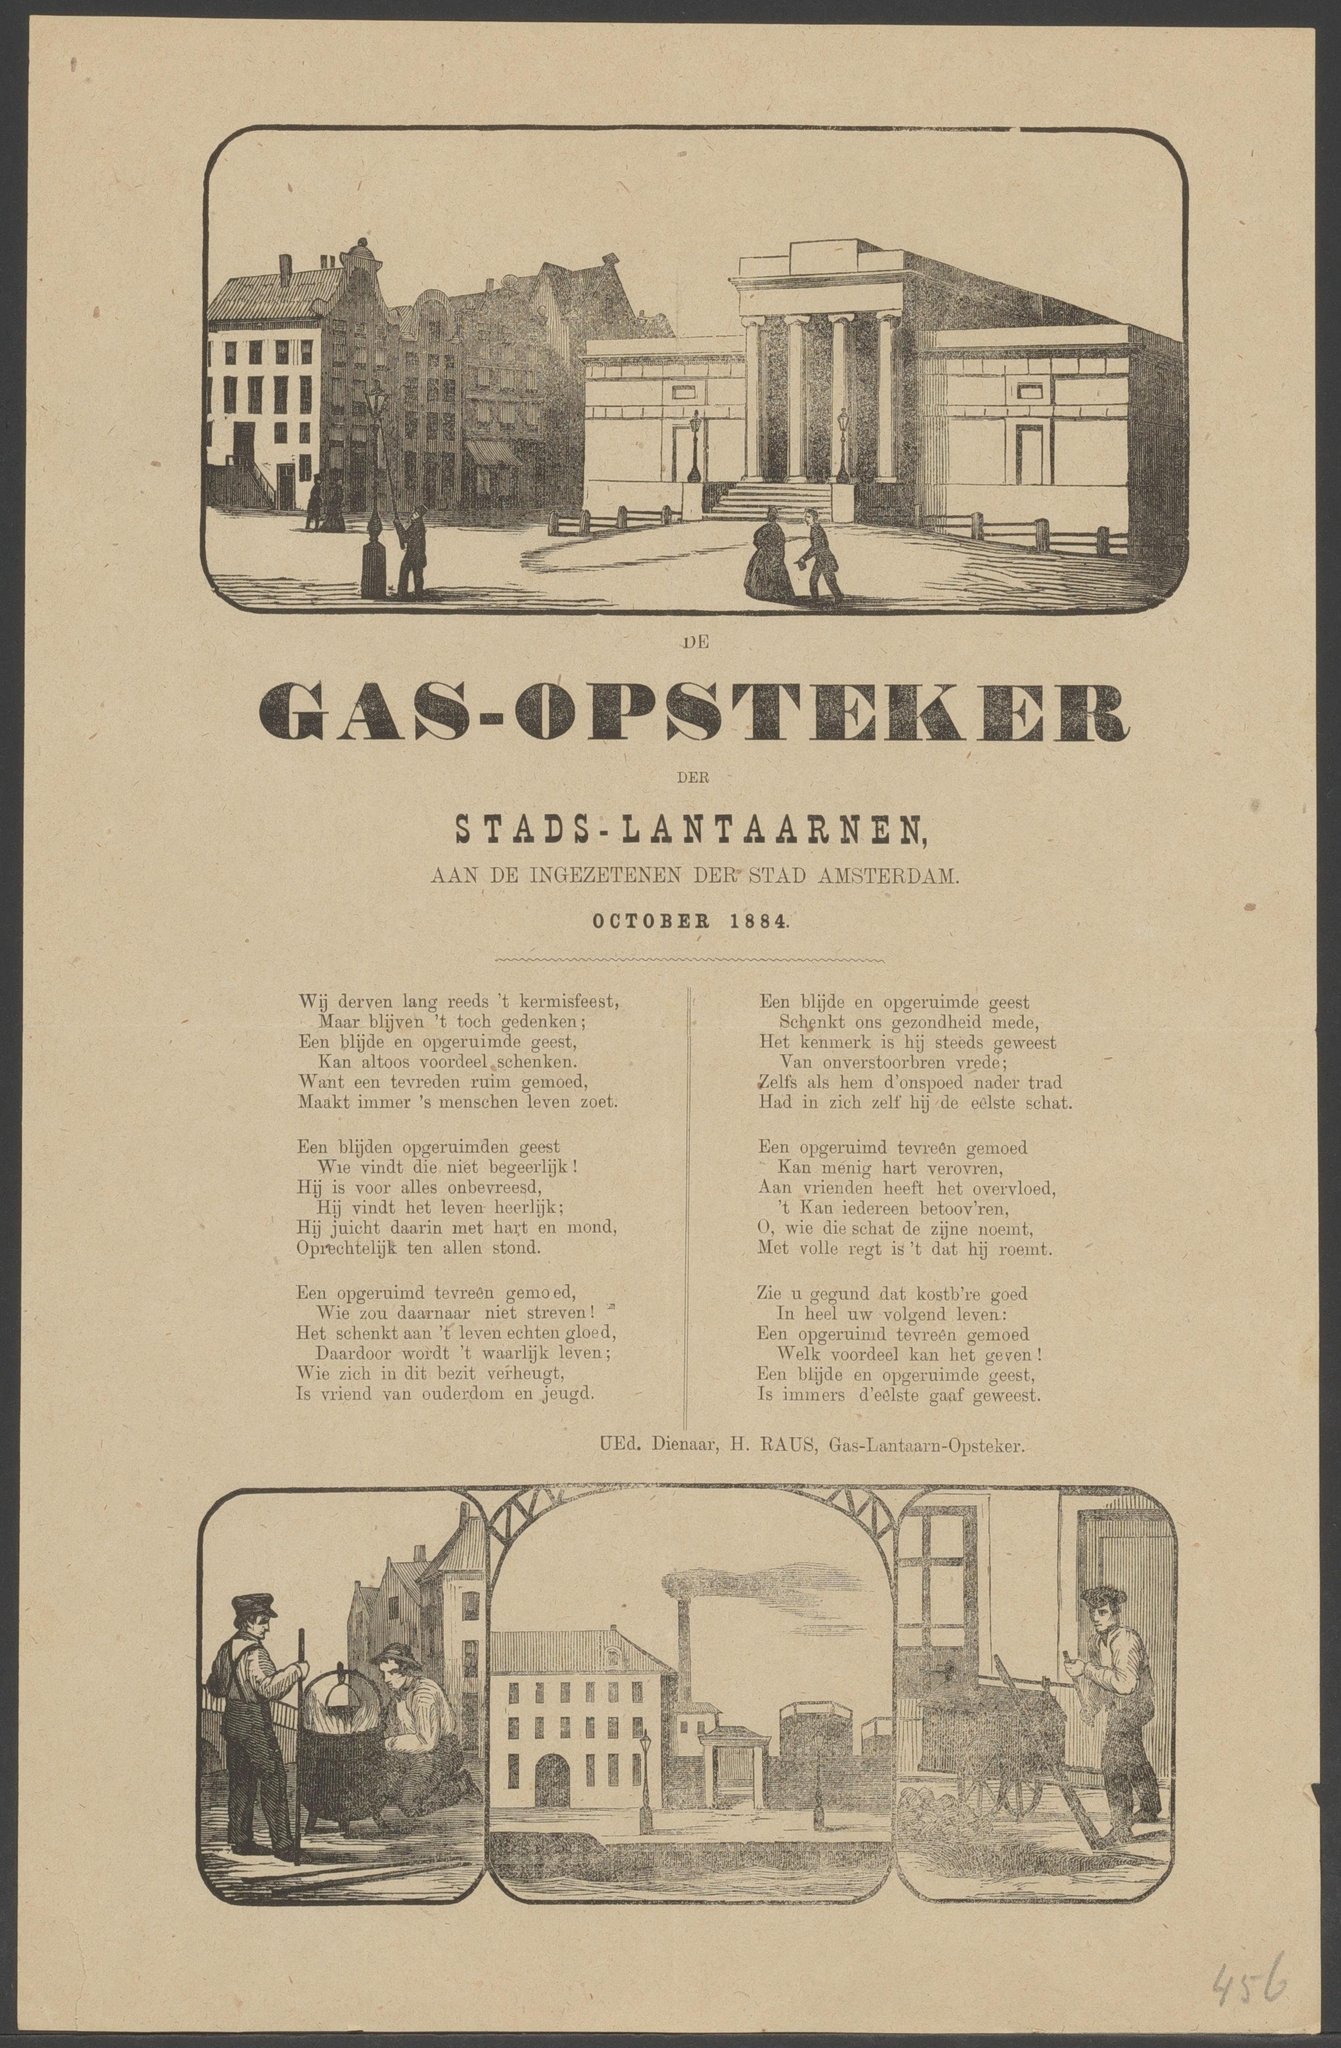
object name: print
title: Kermiswens van de gaslantaarnopstekers van Amsterdam voor het jaar 1884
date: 1884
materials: paper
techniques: letterpress printing, engraving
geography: amsterdam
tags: gas-lamp, gas supply, digging (industrial process), street lighting, amsterdam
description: Kermiswens van de Amsterdamse gaslantaarnopstekers voor het jaar 1884. Centraal een vers in twee kolommen. Bovenaan de Dam met de beurs van Zocher te Amsterdam. Onderaan de Hollandsche Gasfabriek en twee gasfitters aan het werk. Van de gaslantaarnopsteker: H. Raus. Onderwerpsrubrieken binnen de Atlas Zeden en Gewoonten: Zeden en gewoonten in engeren zin, Volksleven, Volksbladen, Nieuwjaars- en Kerstwenschen, Amsterdam.